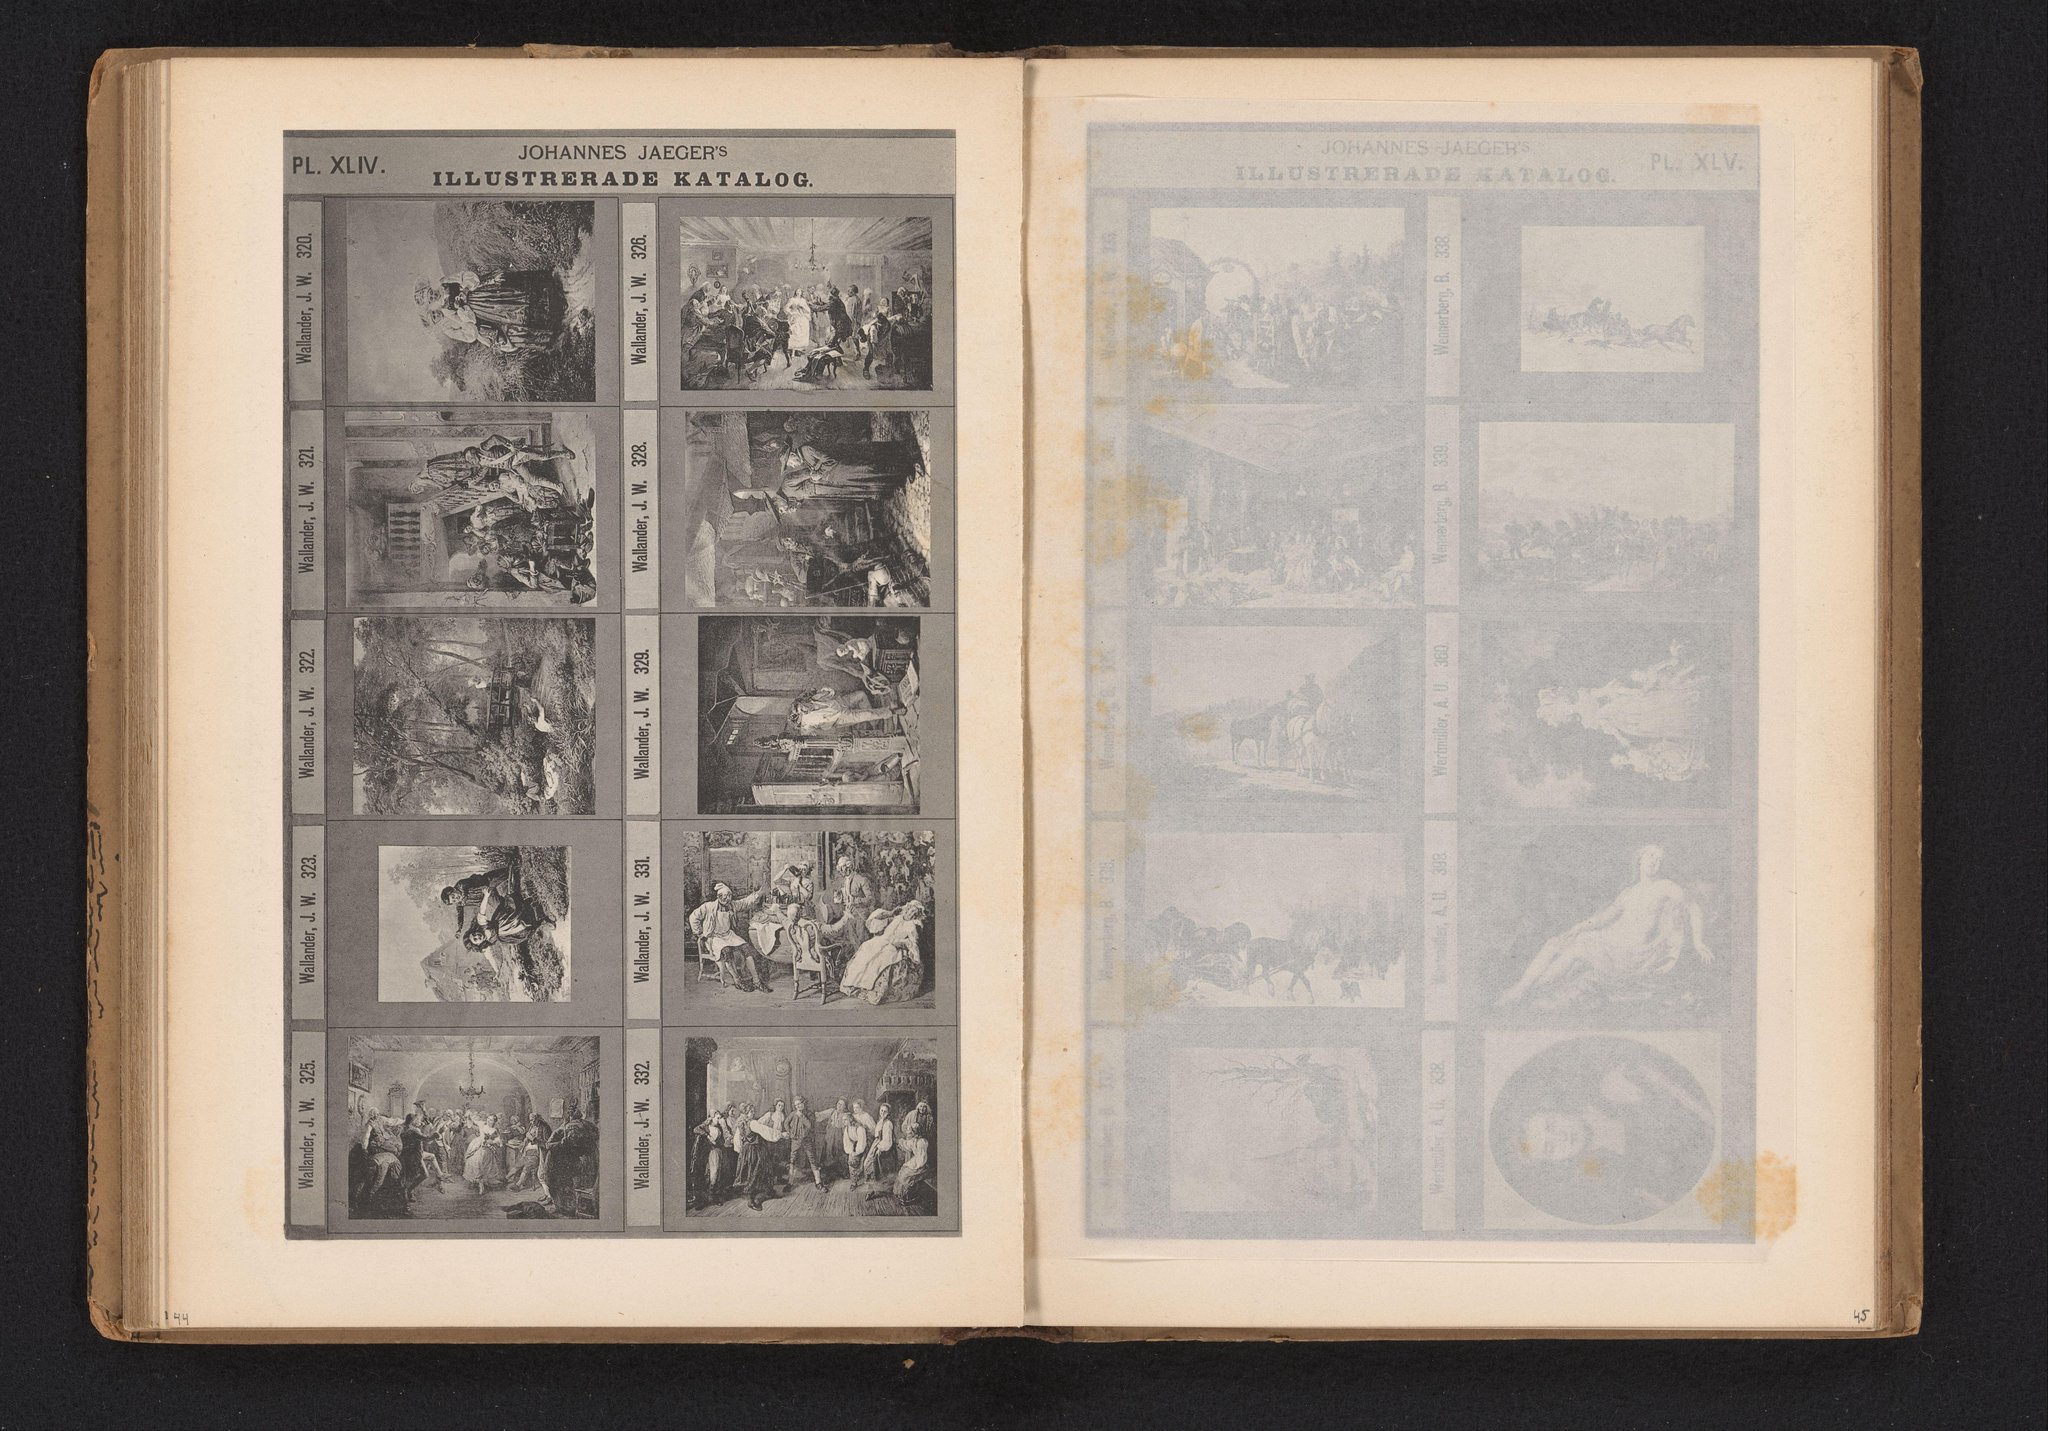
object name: photomechanical print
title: Fotoreproductie van tien schilderijen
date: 1872-1882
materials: paper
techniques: photograph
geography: stockholm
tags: picture, painting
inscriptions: number: ‘PL. XLIV.’